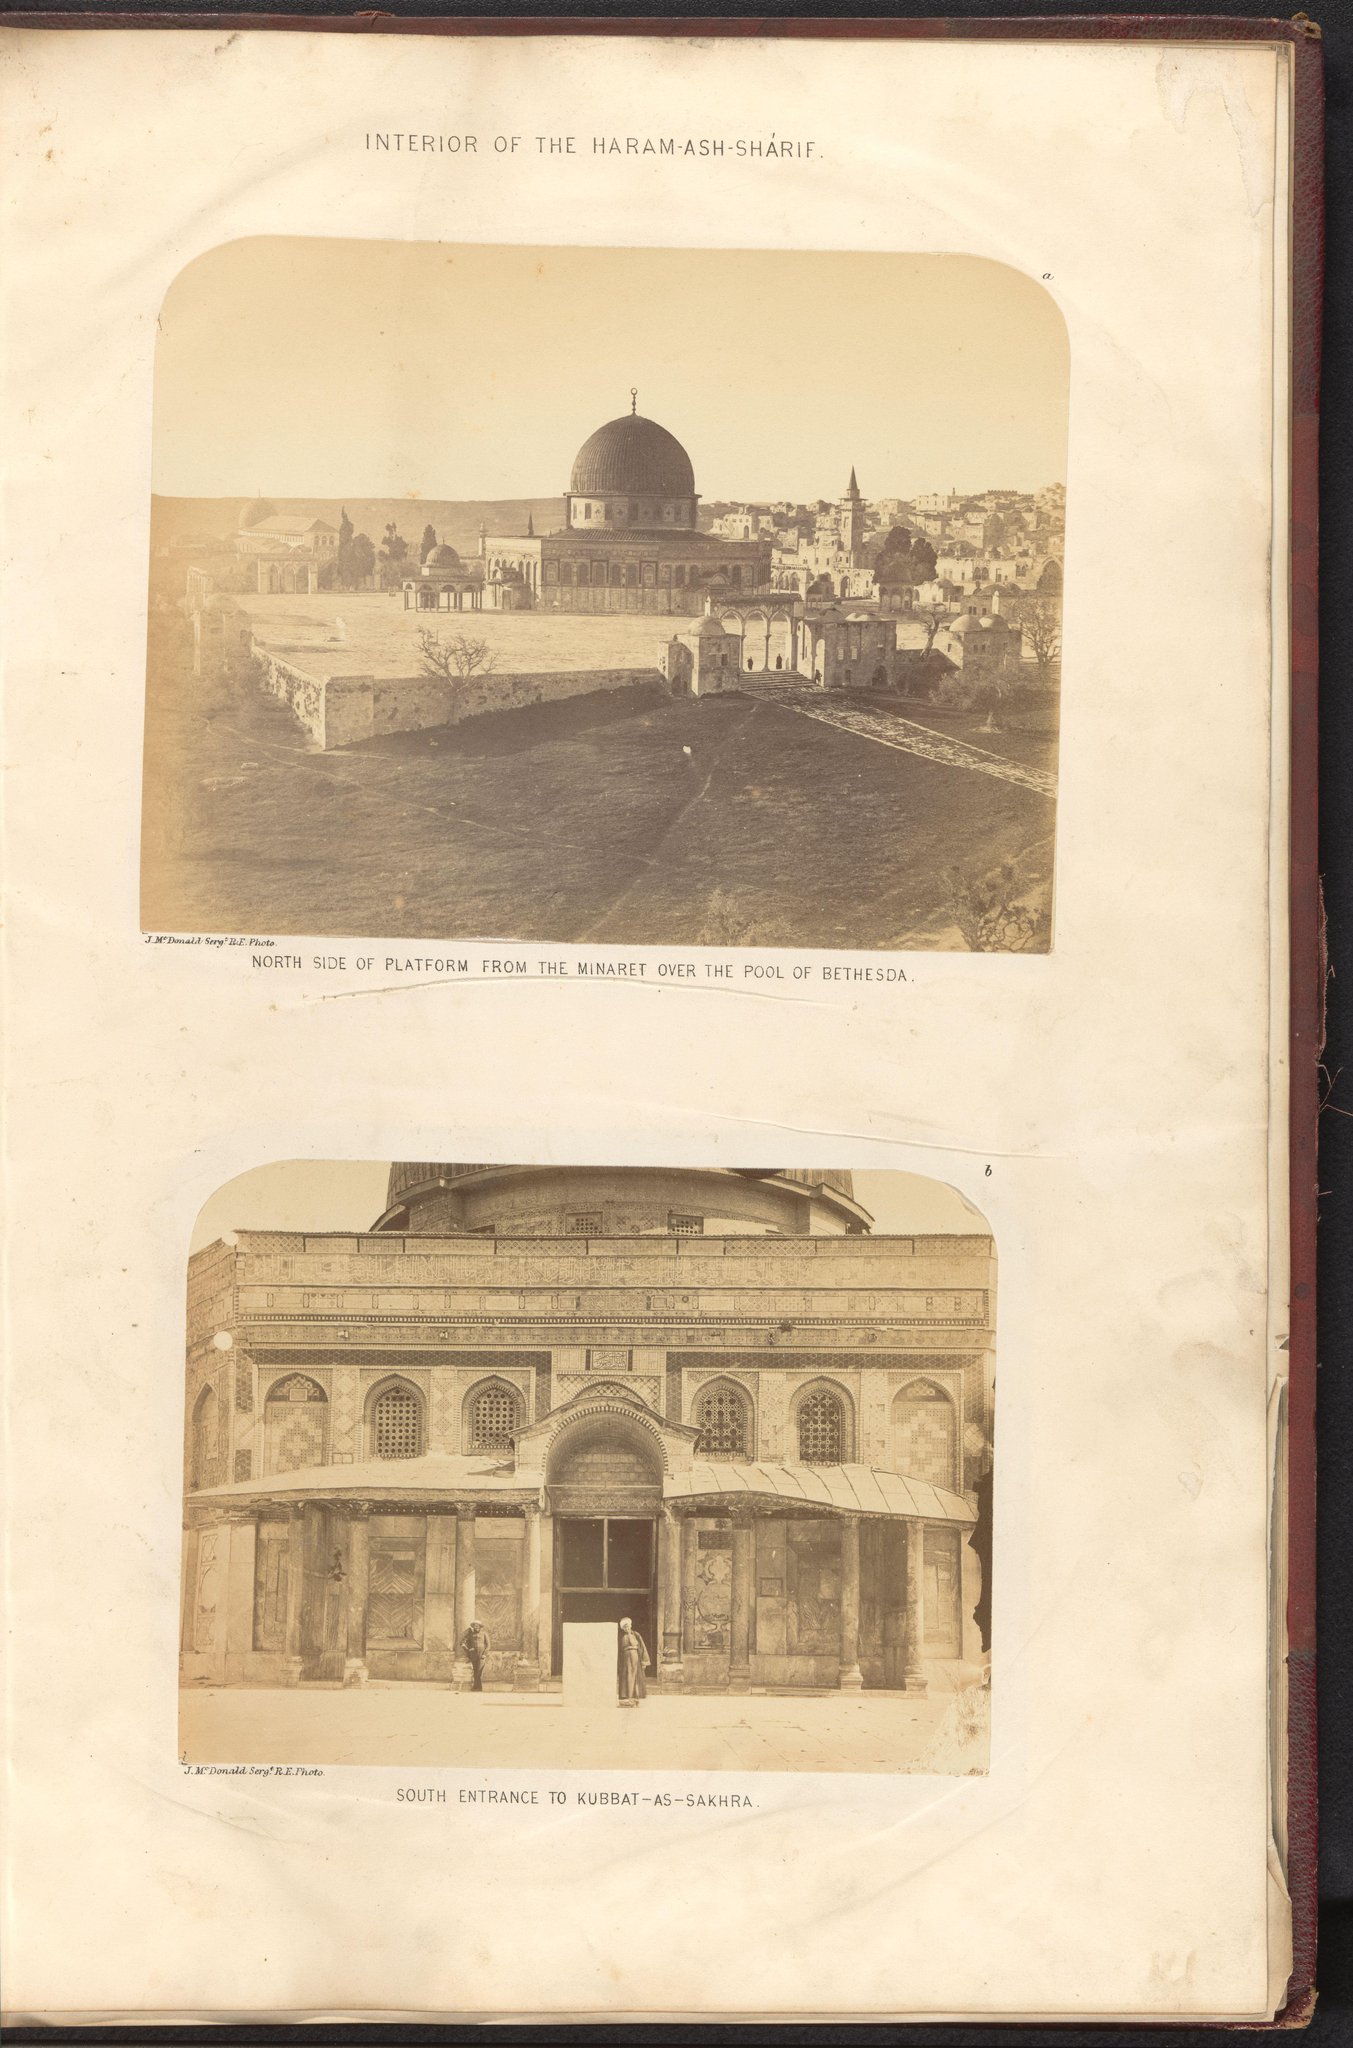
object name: photograph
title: North Side of Platform from the Minaret over the Pool of Bethesda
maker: james mcdonald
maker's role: fotograaf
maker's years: 1822-1885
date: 1860-1865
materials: paper, photographic support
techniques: albumen print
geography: tempelberg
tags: temple, shrine ~ islam, mohammedanism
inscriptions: inscription: ‘a’, inscription: ‘b’